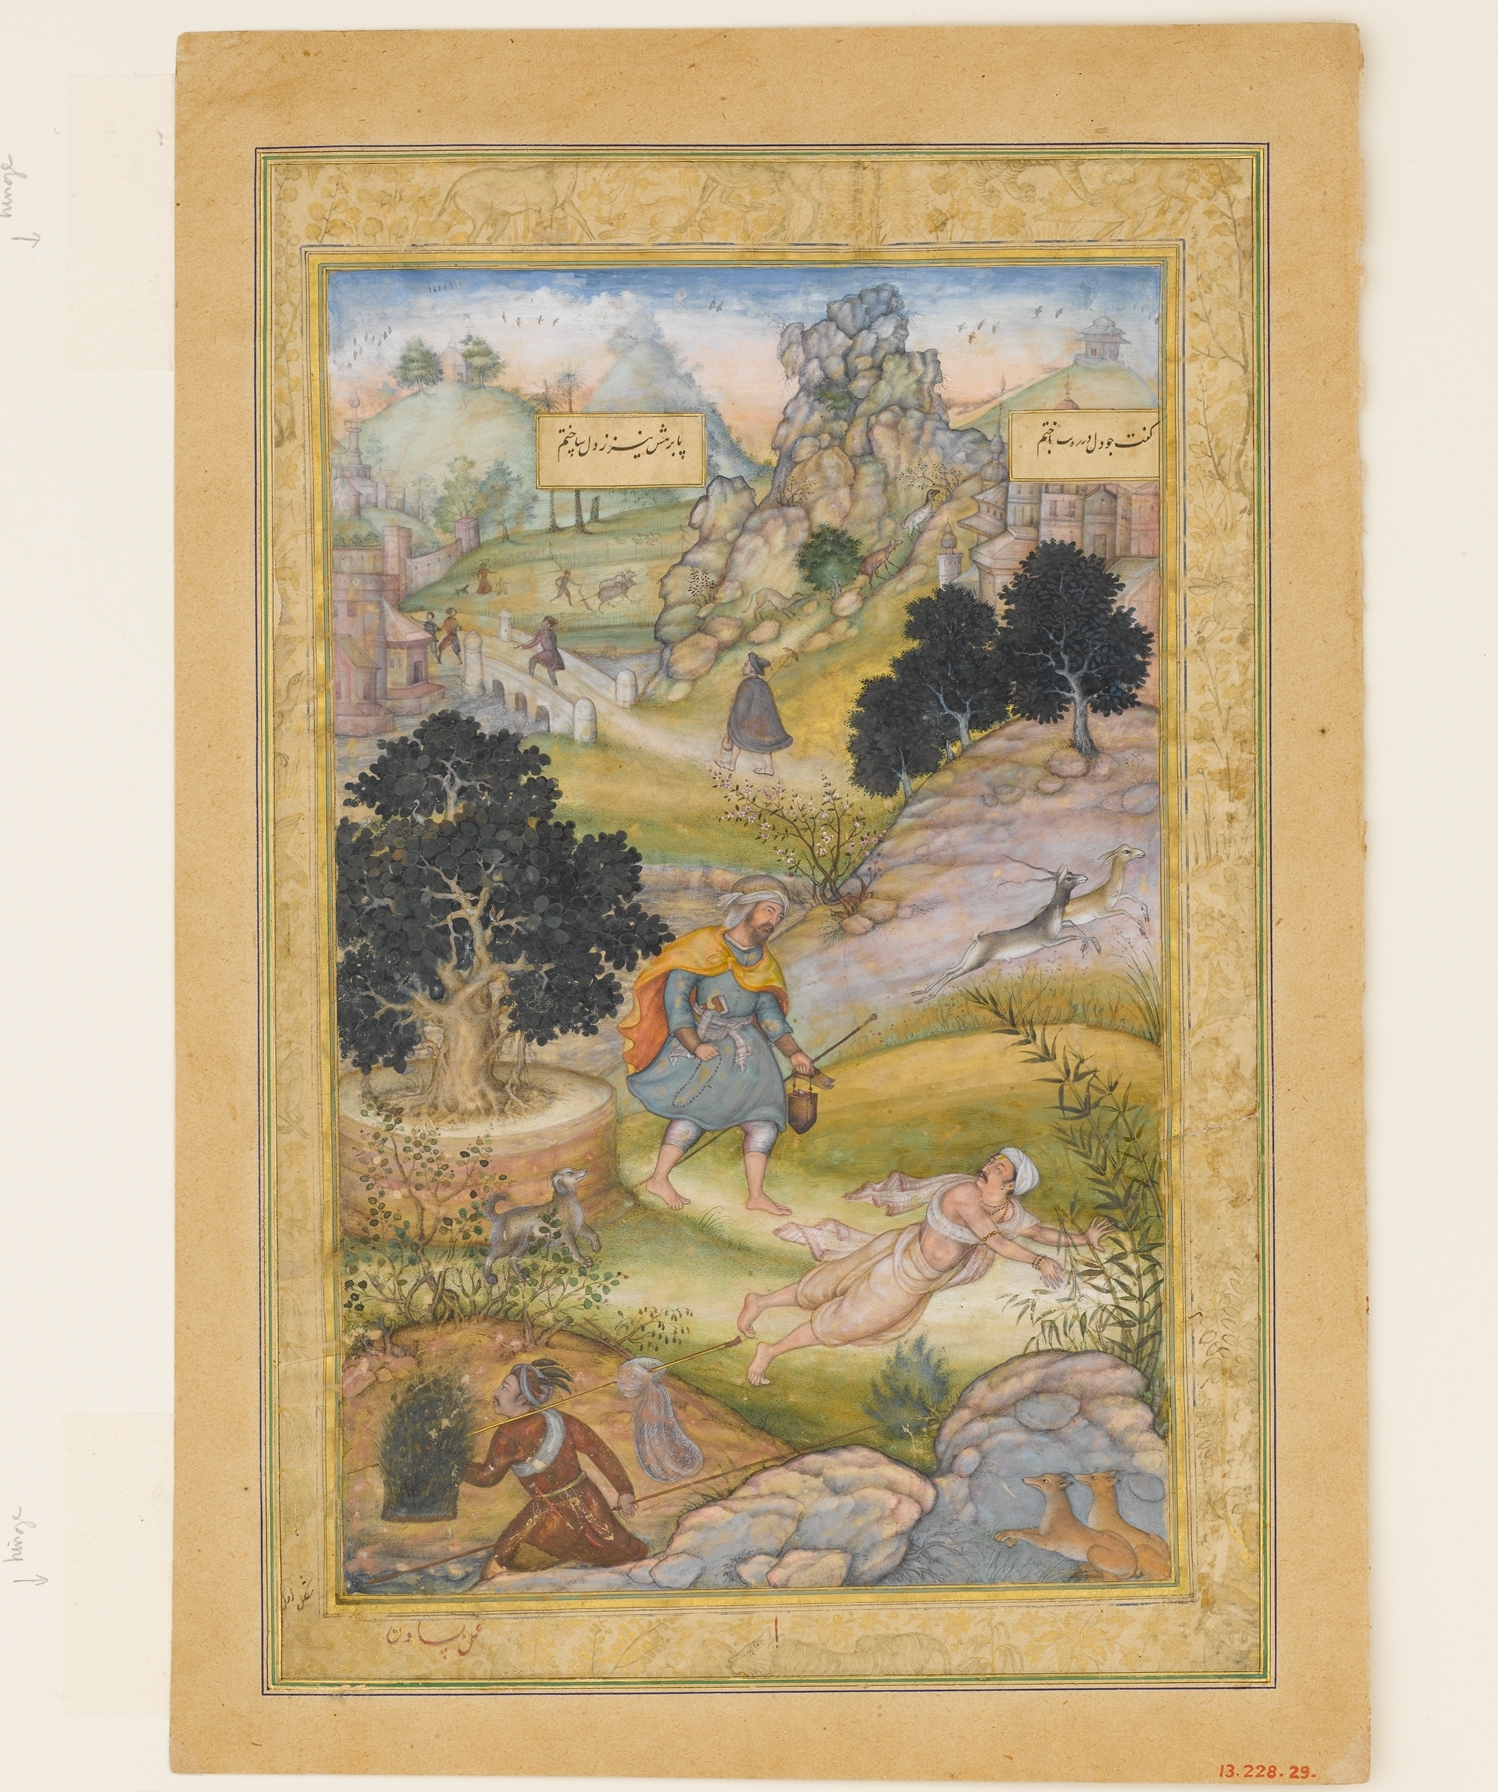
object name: folio from an illustrated manuscript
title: "A Muslim Pilgrim Learns a Lesson in Piety from a Brahman", Folio from a Khamsa (Quintet) of Amir Khusrau Dihlavi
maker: amir khusrau dihlavi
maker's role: author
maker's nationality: indian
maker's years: 1228-1350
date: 1597-1598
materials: gold, ink, paper, watercolor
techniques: dyeing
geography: india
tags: animals,men,landscapes